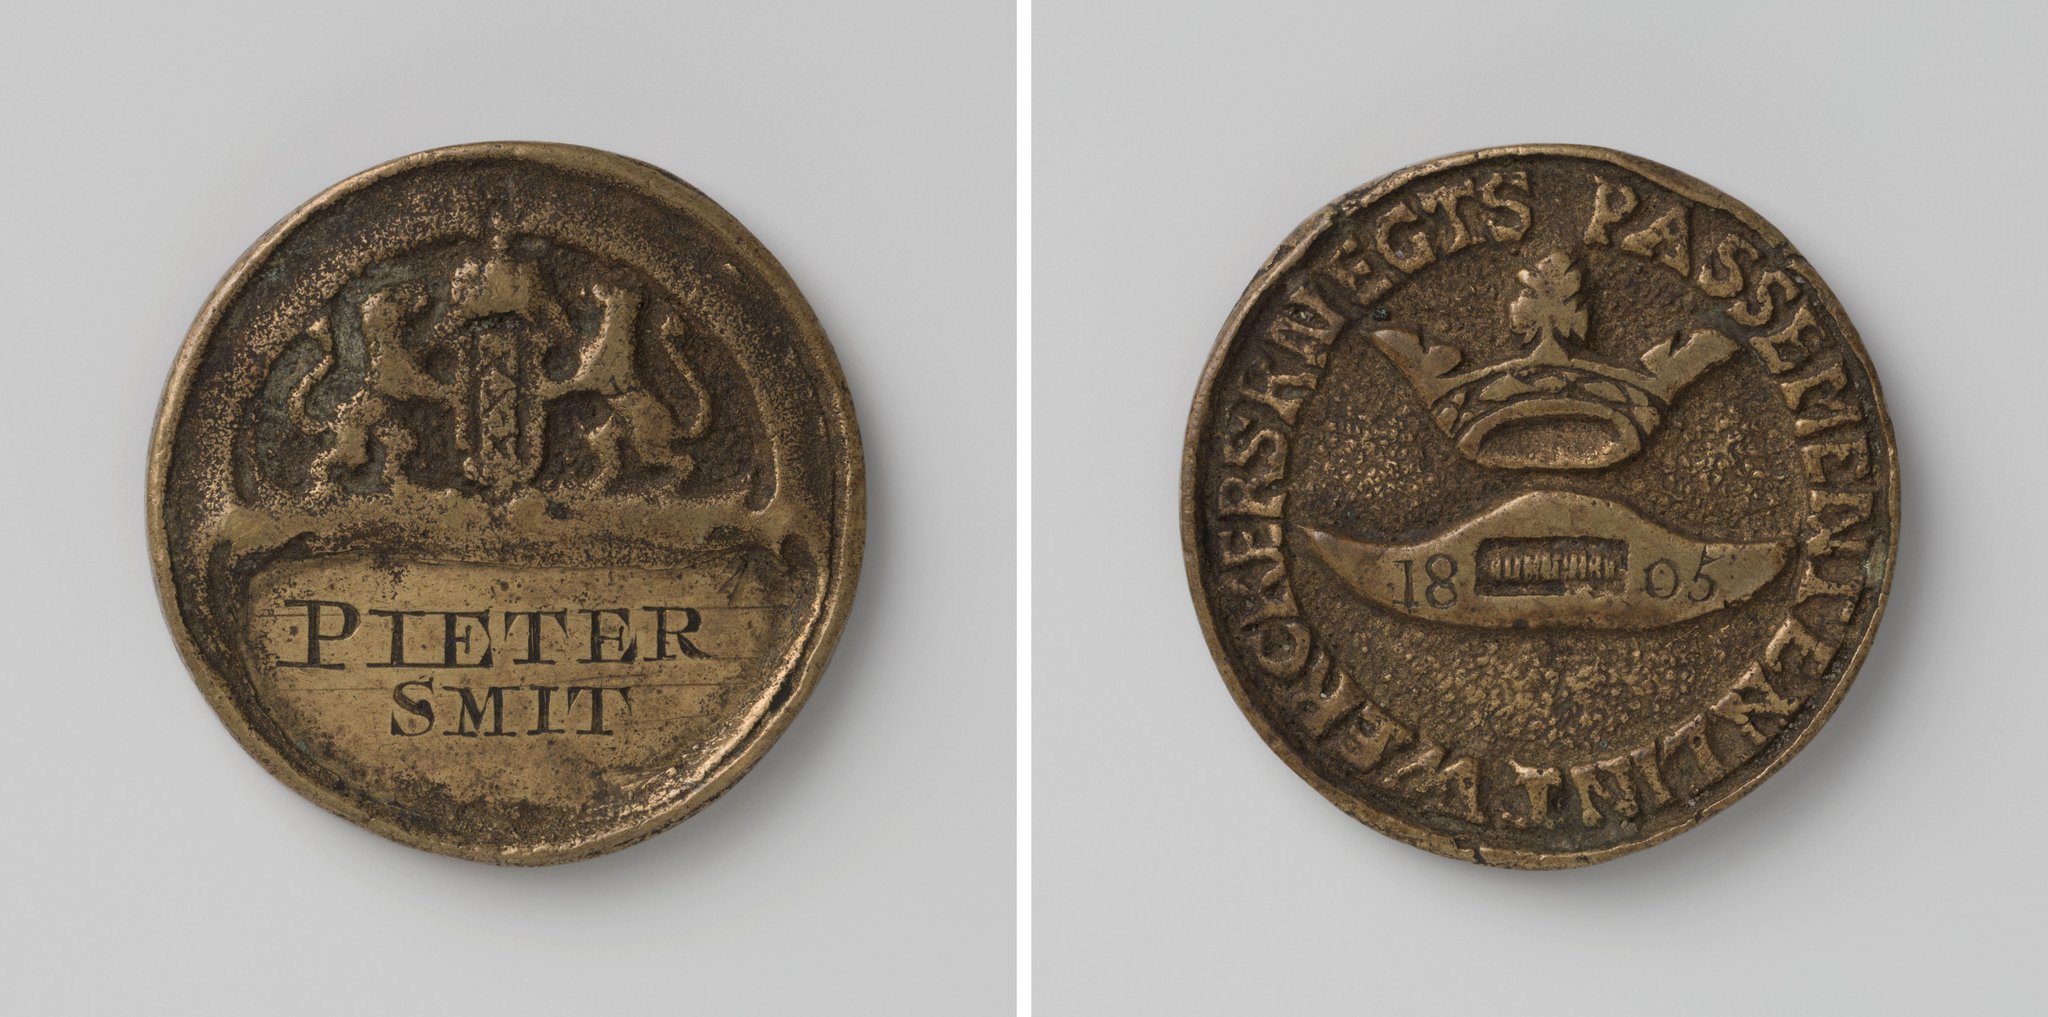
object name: medal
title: Knechts van het passement- en lintwerkersgilde van Amsterdam, gildepenning van Pieter Smit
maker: Anonymous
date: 1805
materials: brass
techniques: casting, engraving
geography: amsterdam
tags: amsterdam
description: Messing penning. Voorzijde: gekroond wapenschild, geflankeerd door twee leeuwen boven cartouche met opschrift. Keerzijde: weversspoel onder kroon binnen omschrift; op uiteinden van spoel: jaartal.